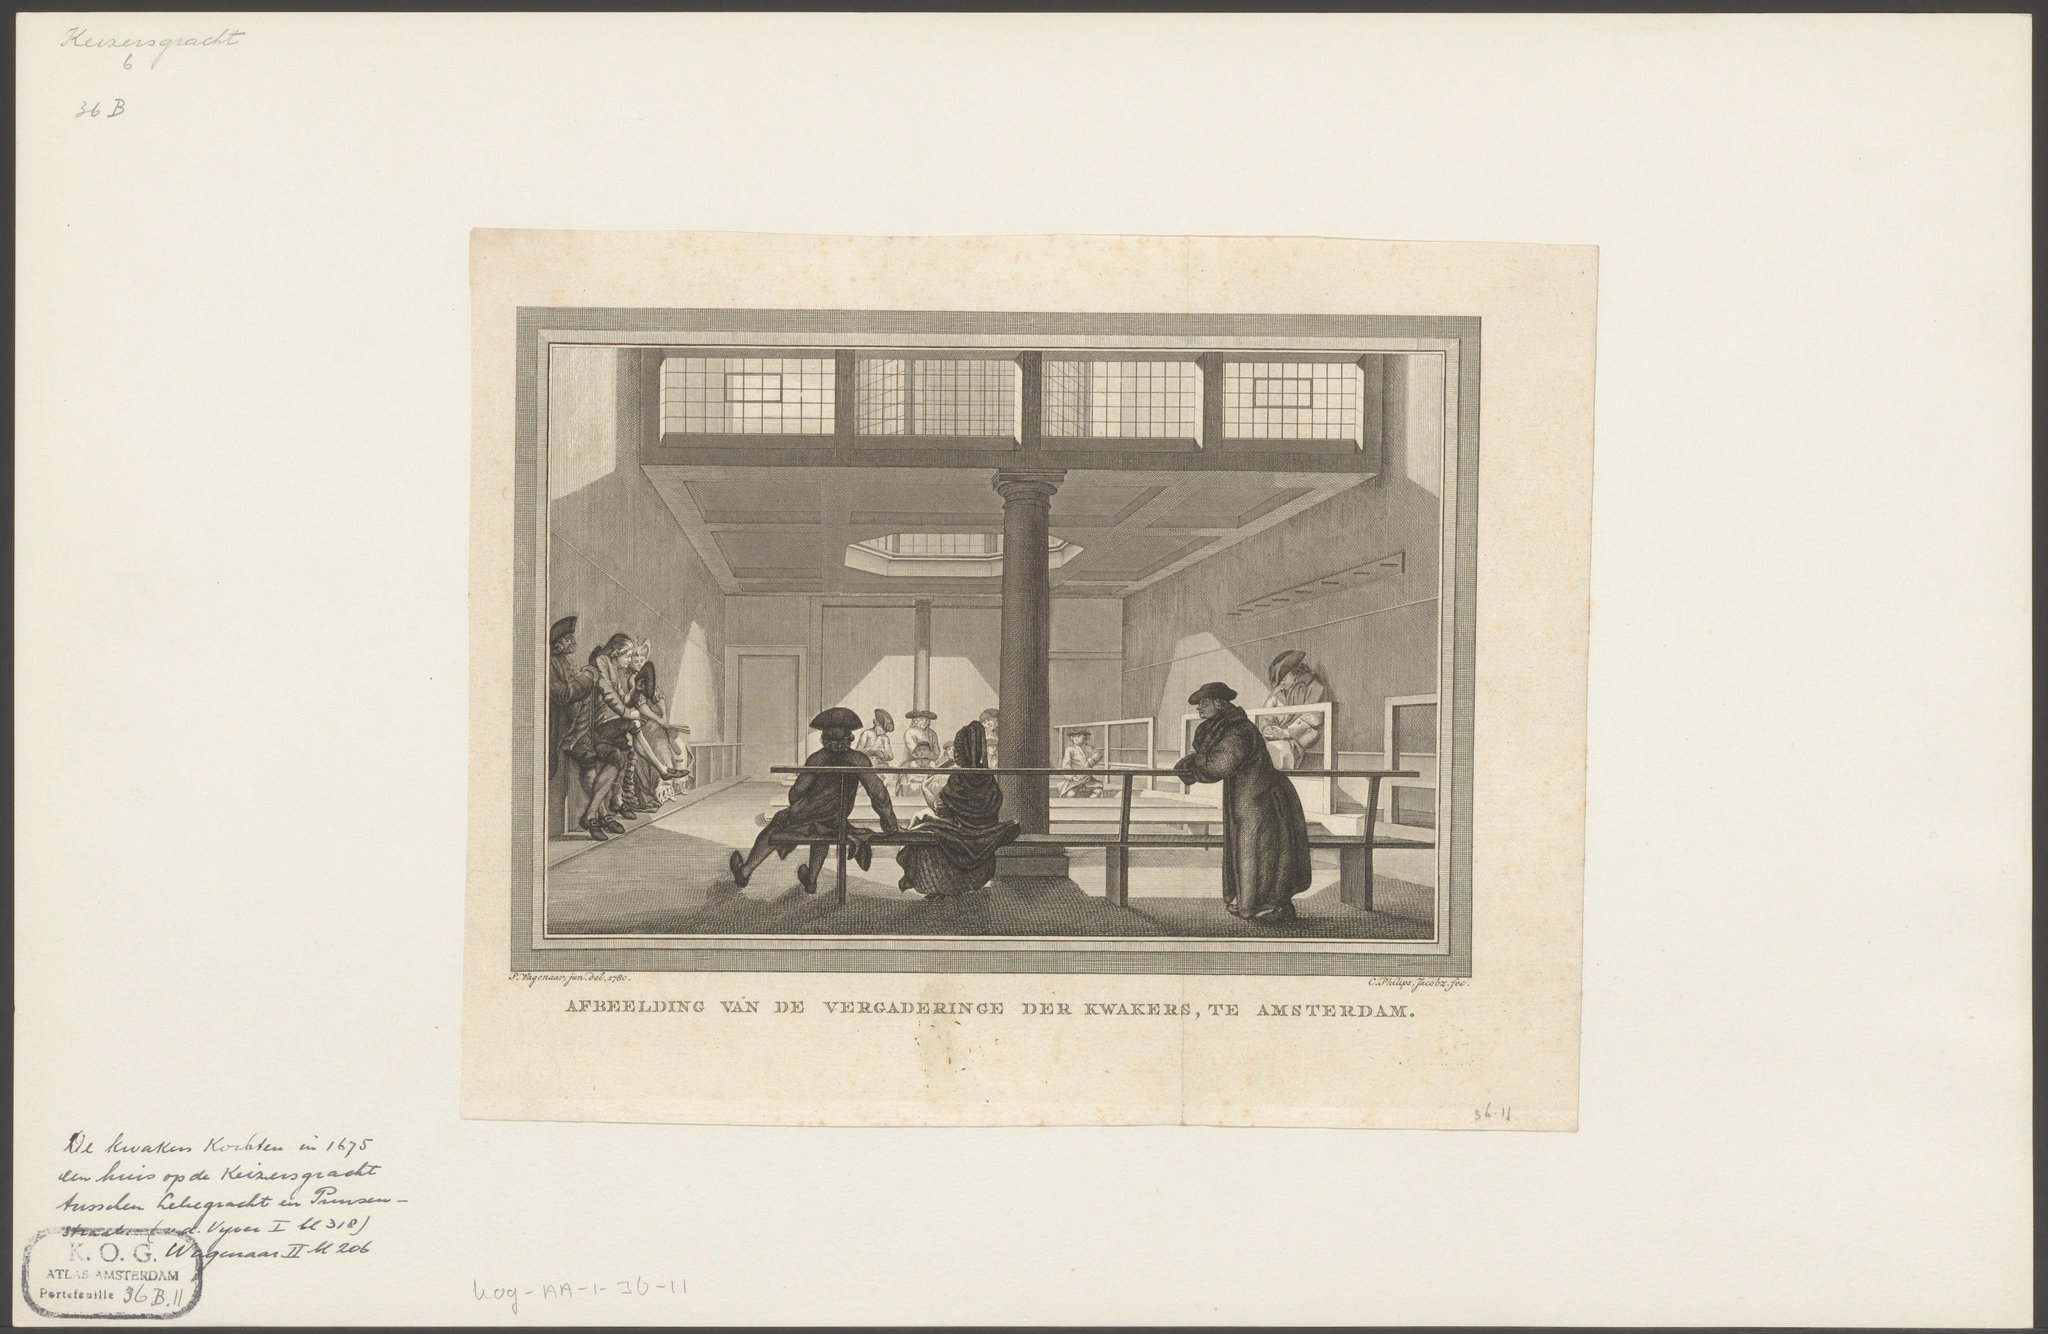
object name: print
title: Afbeelding van de vergaderinge der Kwakers, te Amsterdam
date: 1780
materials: paper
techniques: etching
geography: amsterdam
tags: protestant churches and denominations (with name), negotiations, conference ~ diplomacy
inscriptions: collector's mark: Lugt 1641b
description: Een groep Quakers vergadert in een kerk te Amsterdam. Onderwerpsrubriek binnen de Atlas Amsterdam: Kerkwezen: Vrienden-Gemeente (Kwakers).